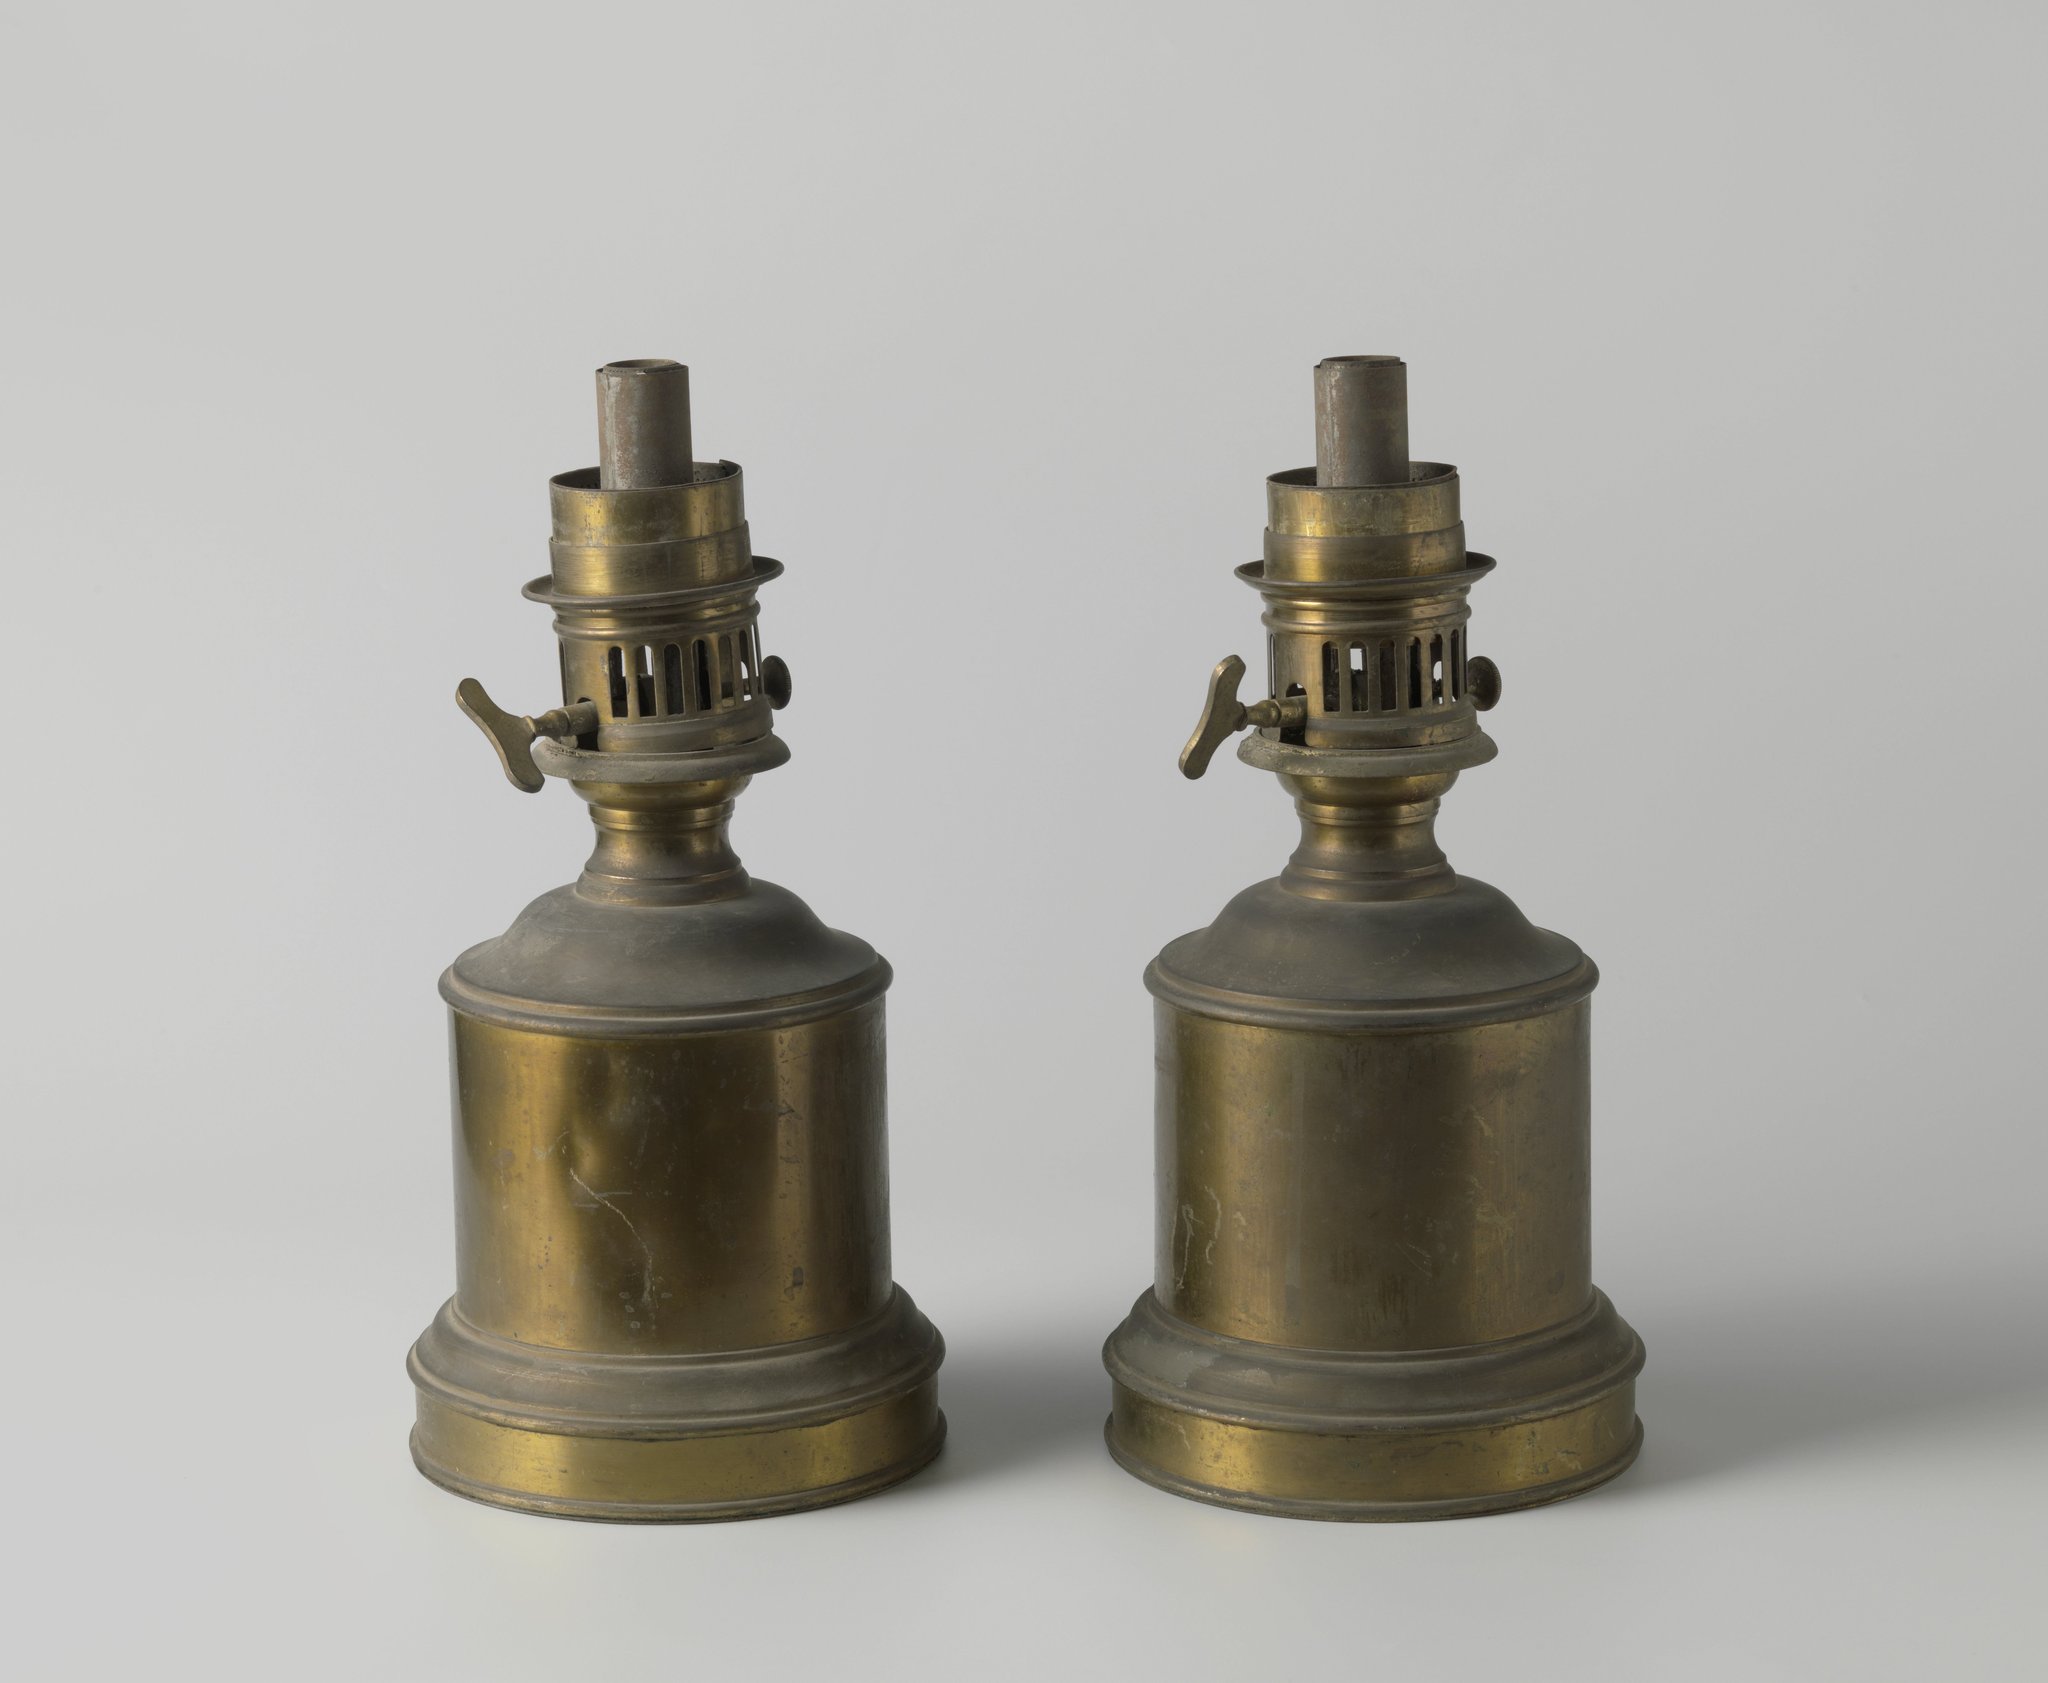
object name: oil lamp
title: Two Lamps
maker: Anonymous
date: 1850-1870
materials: brass, copper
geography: netherlands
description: Deze voorwerpen, omschreven als ‘moderateurlampen’, zijn zonder nummer aangetroffen en de identificatie is gebaseerd op eliminatie. Geen verdere historische gegevens zijn bekend.